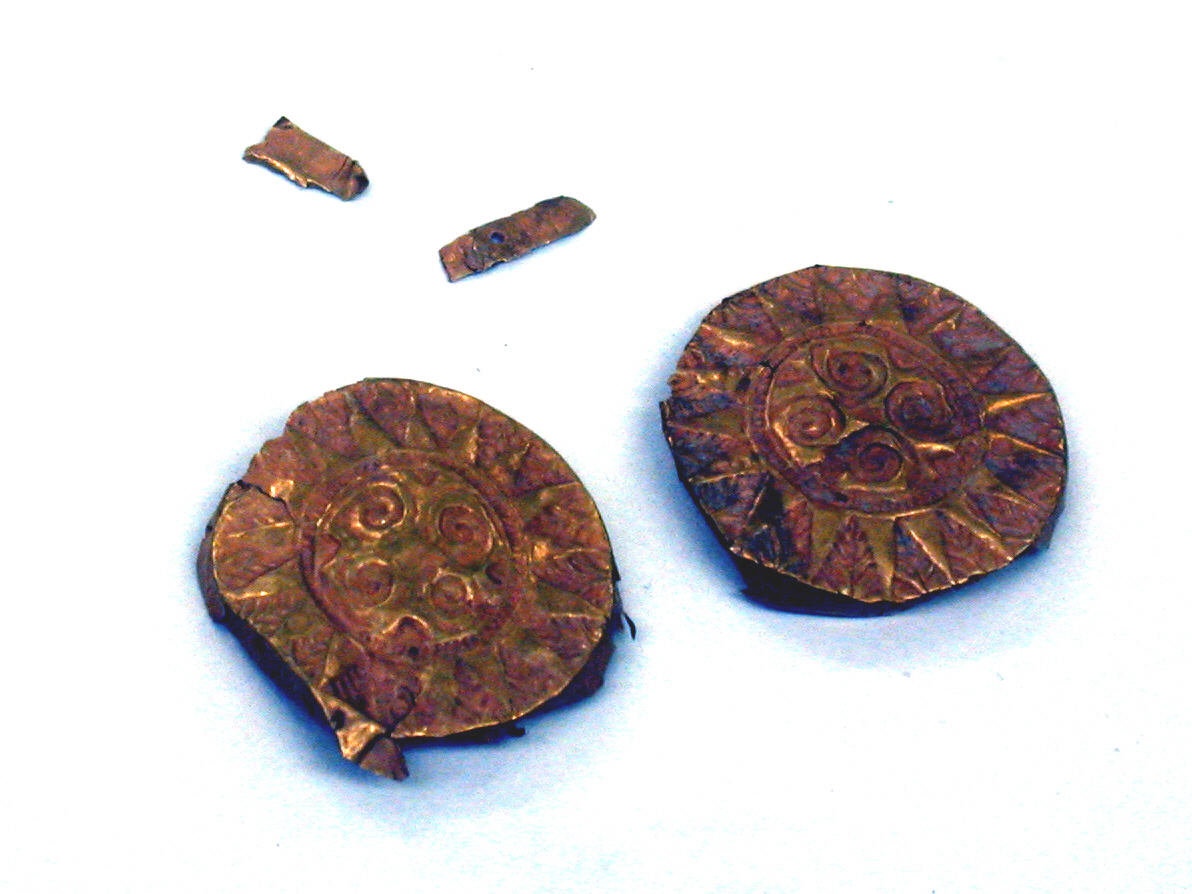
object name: headdress fragment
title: Fragment of a Headdress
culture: mindanao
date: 1301-1500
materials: gold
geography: philippines